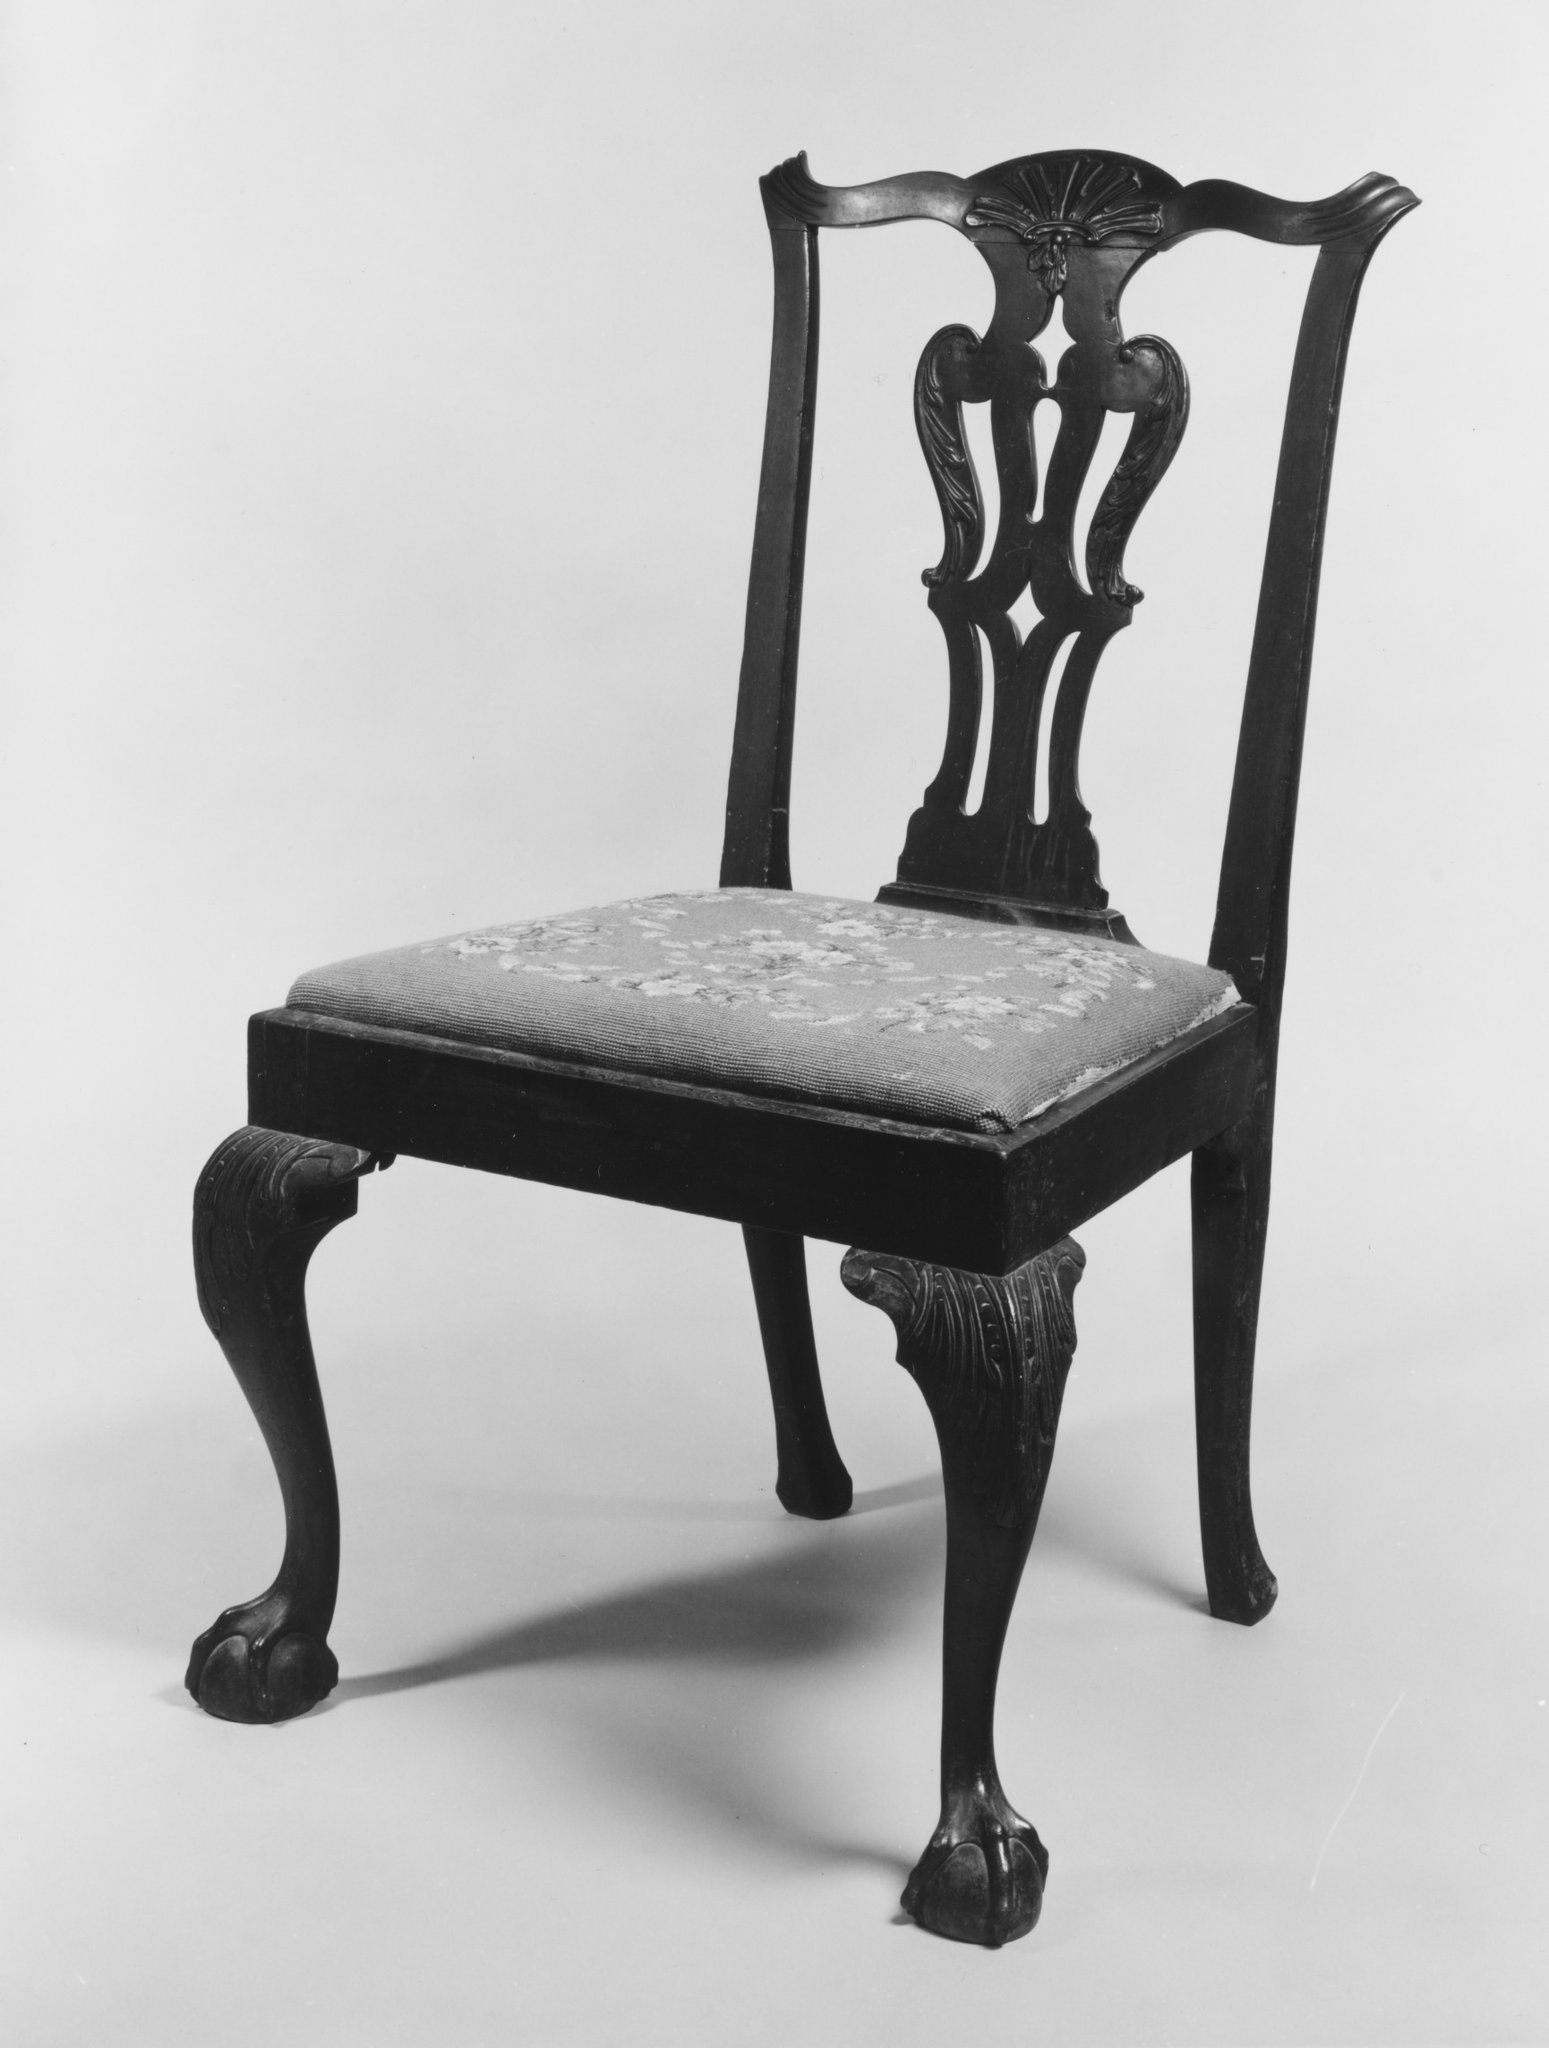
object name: chair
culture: american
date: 1760-1780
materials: wood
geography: united states